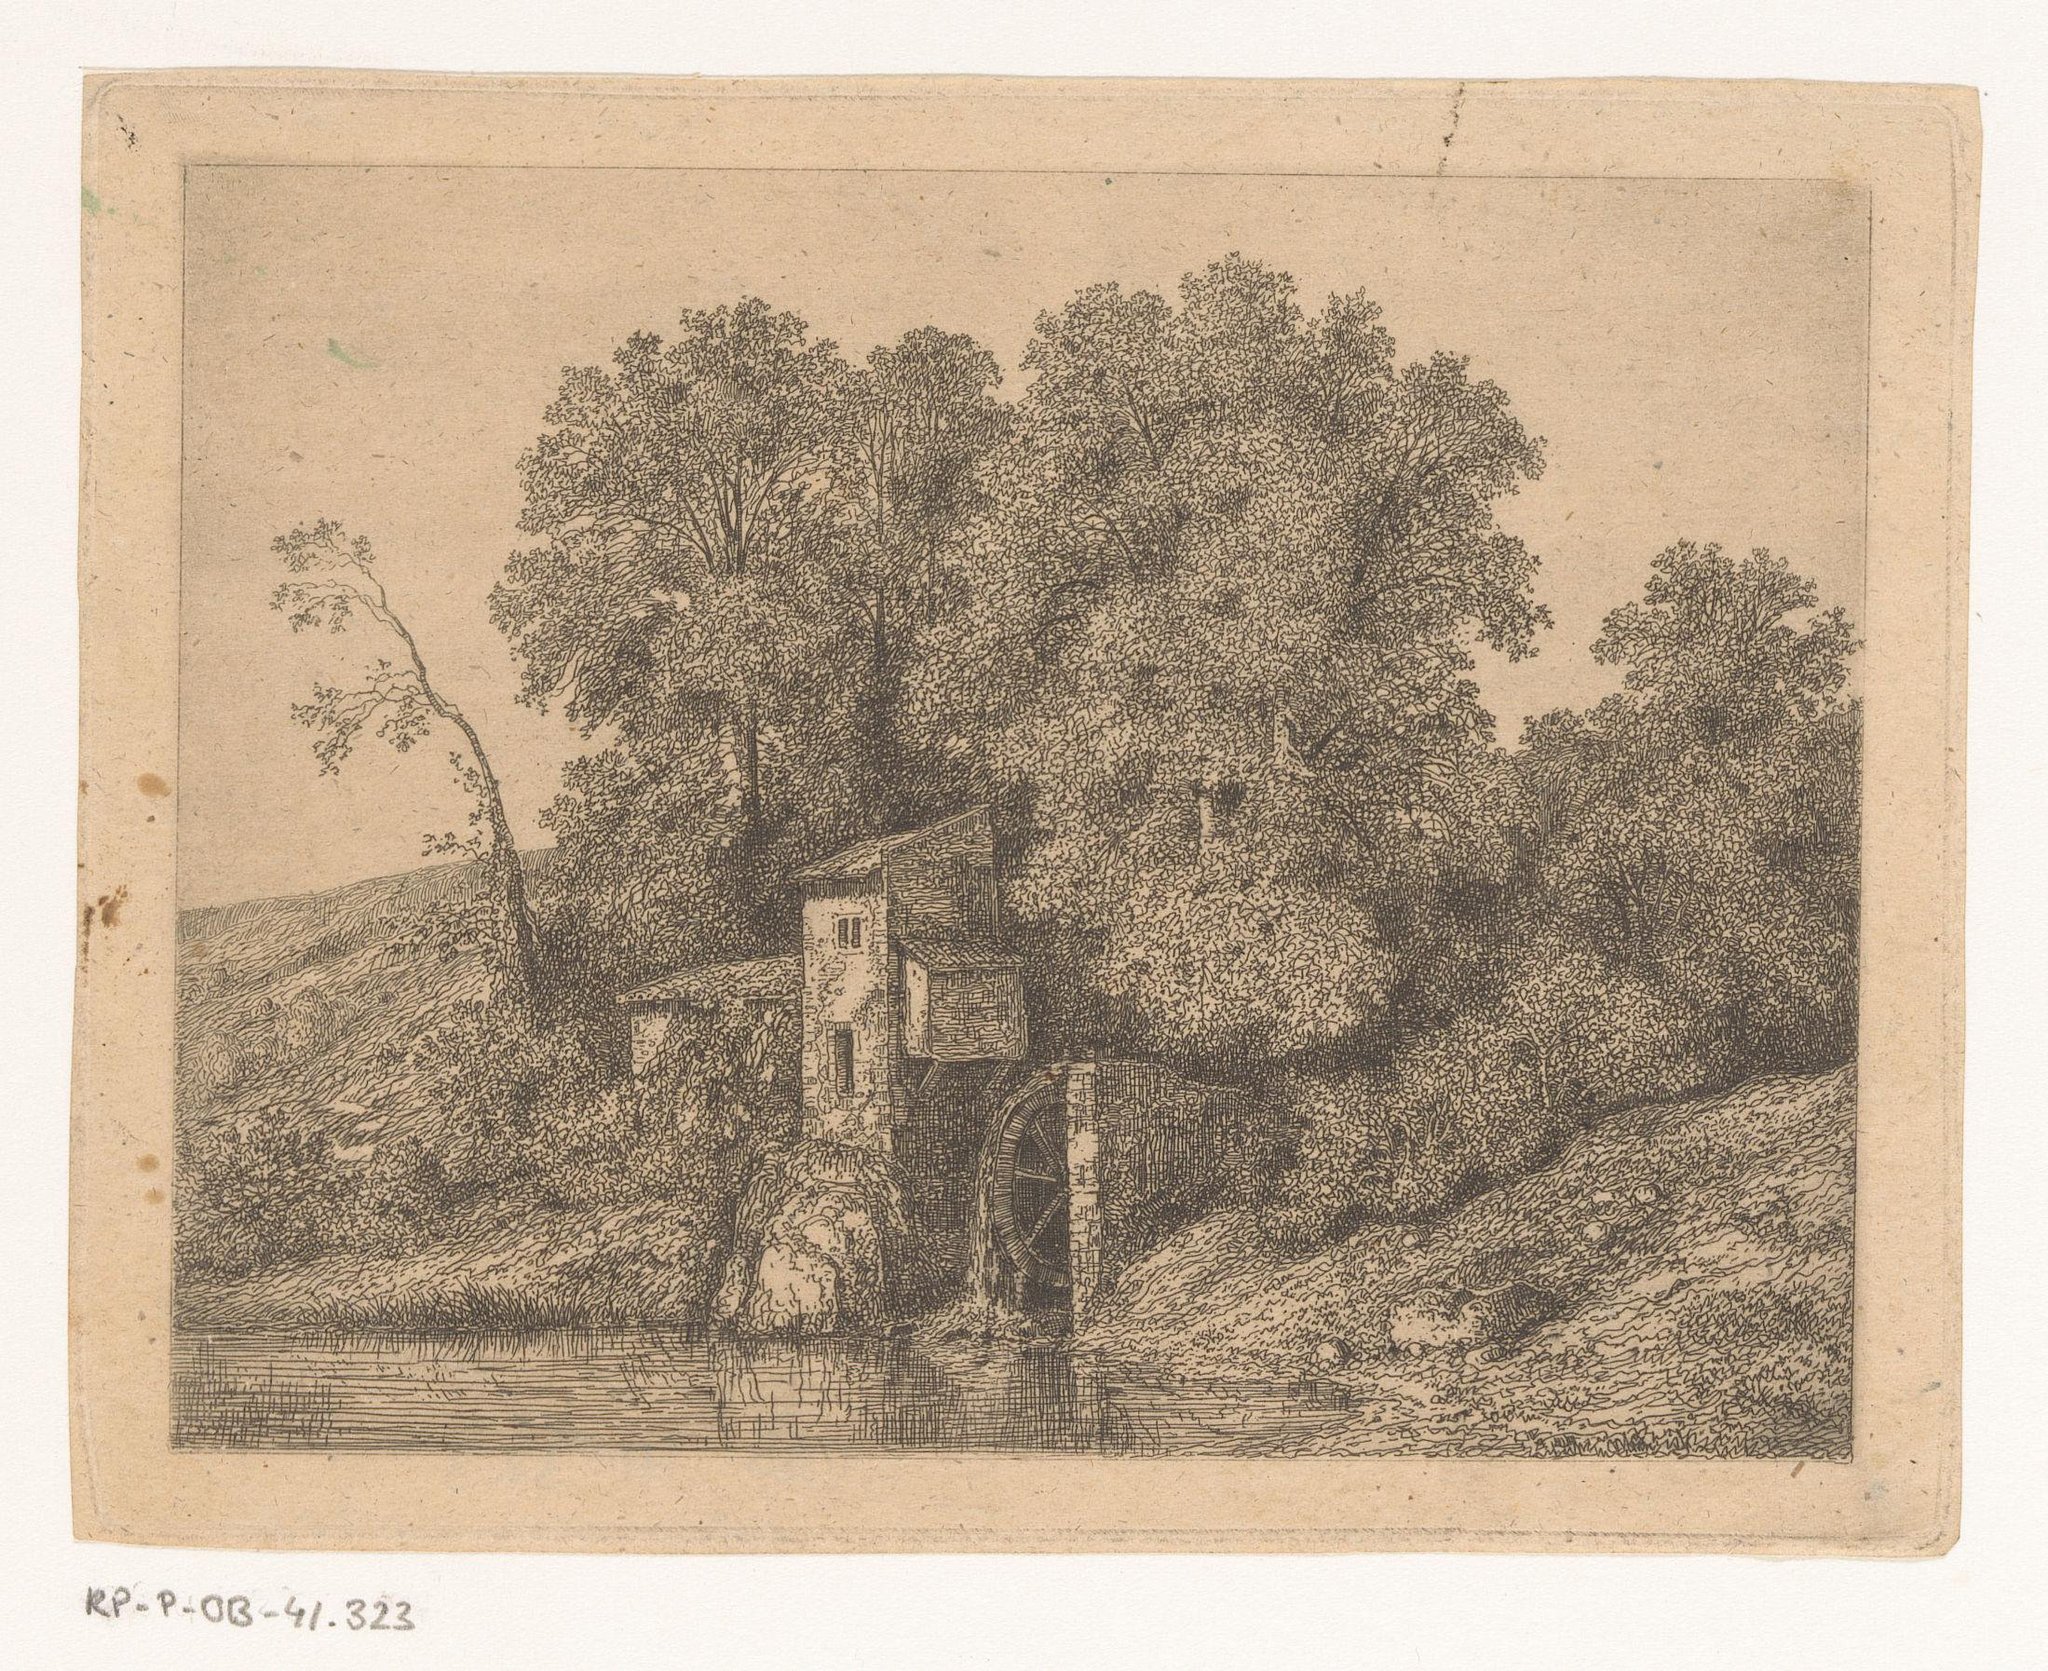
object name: print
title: Watermolen temidden van bomen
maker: jean alexis achard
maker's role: print maker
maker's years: 1807-1884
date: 1817-1884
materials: paper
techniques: etching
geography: france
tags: trees, watermill in landscape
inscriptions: collector's mark: Lugt 2228, inscription: ‘[...] Achard?’